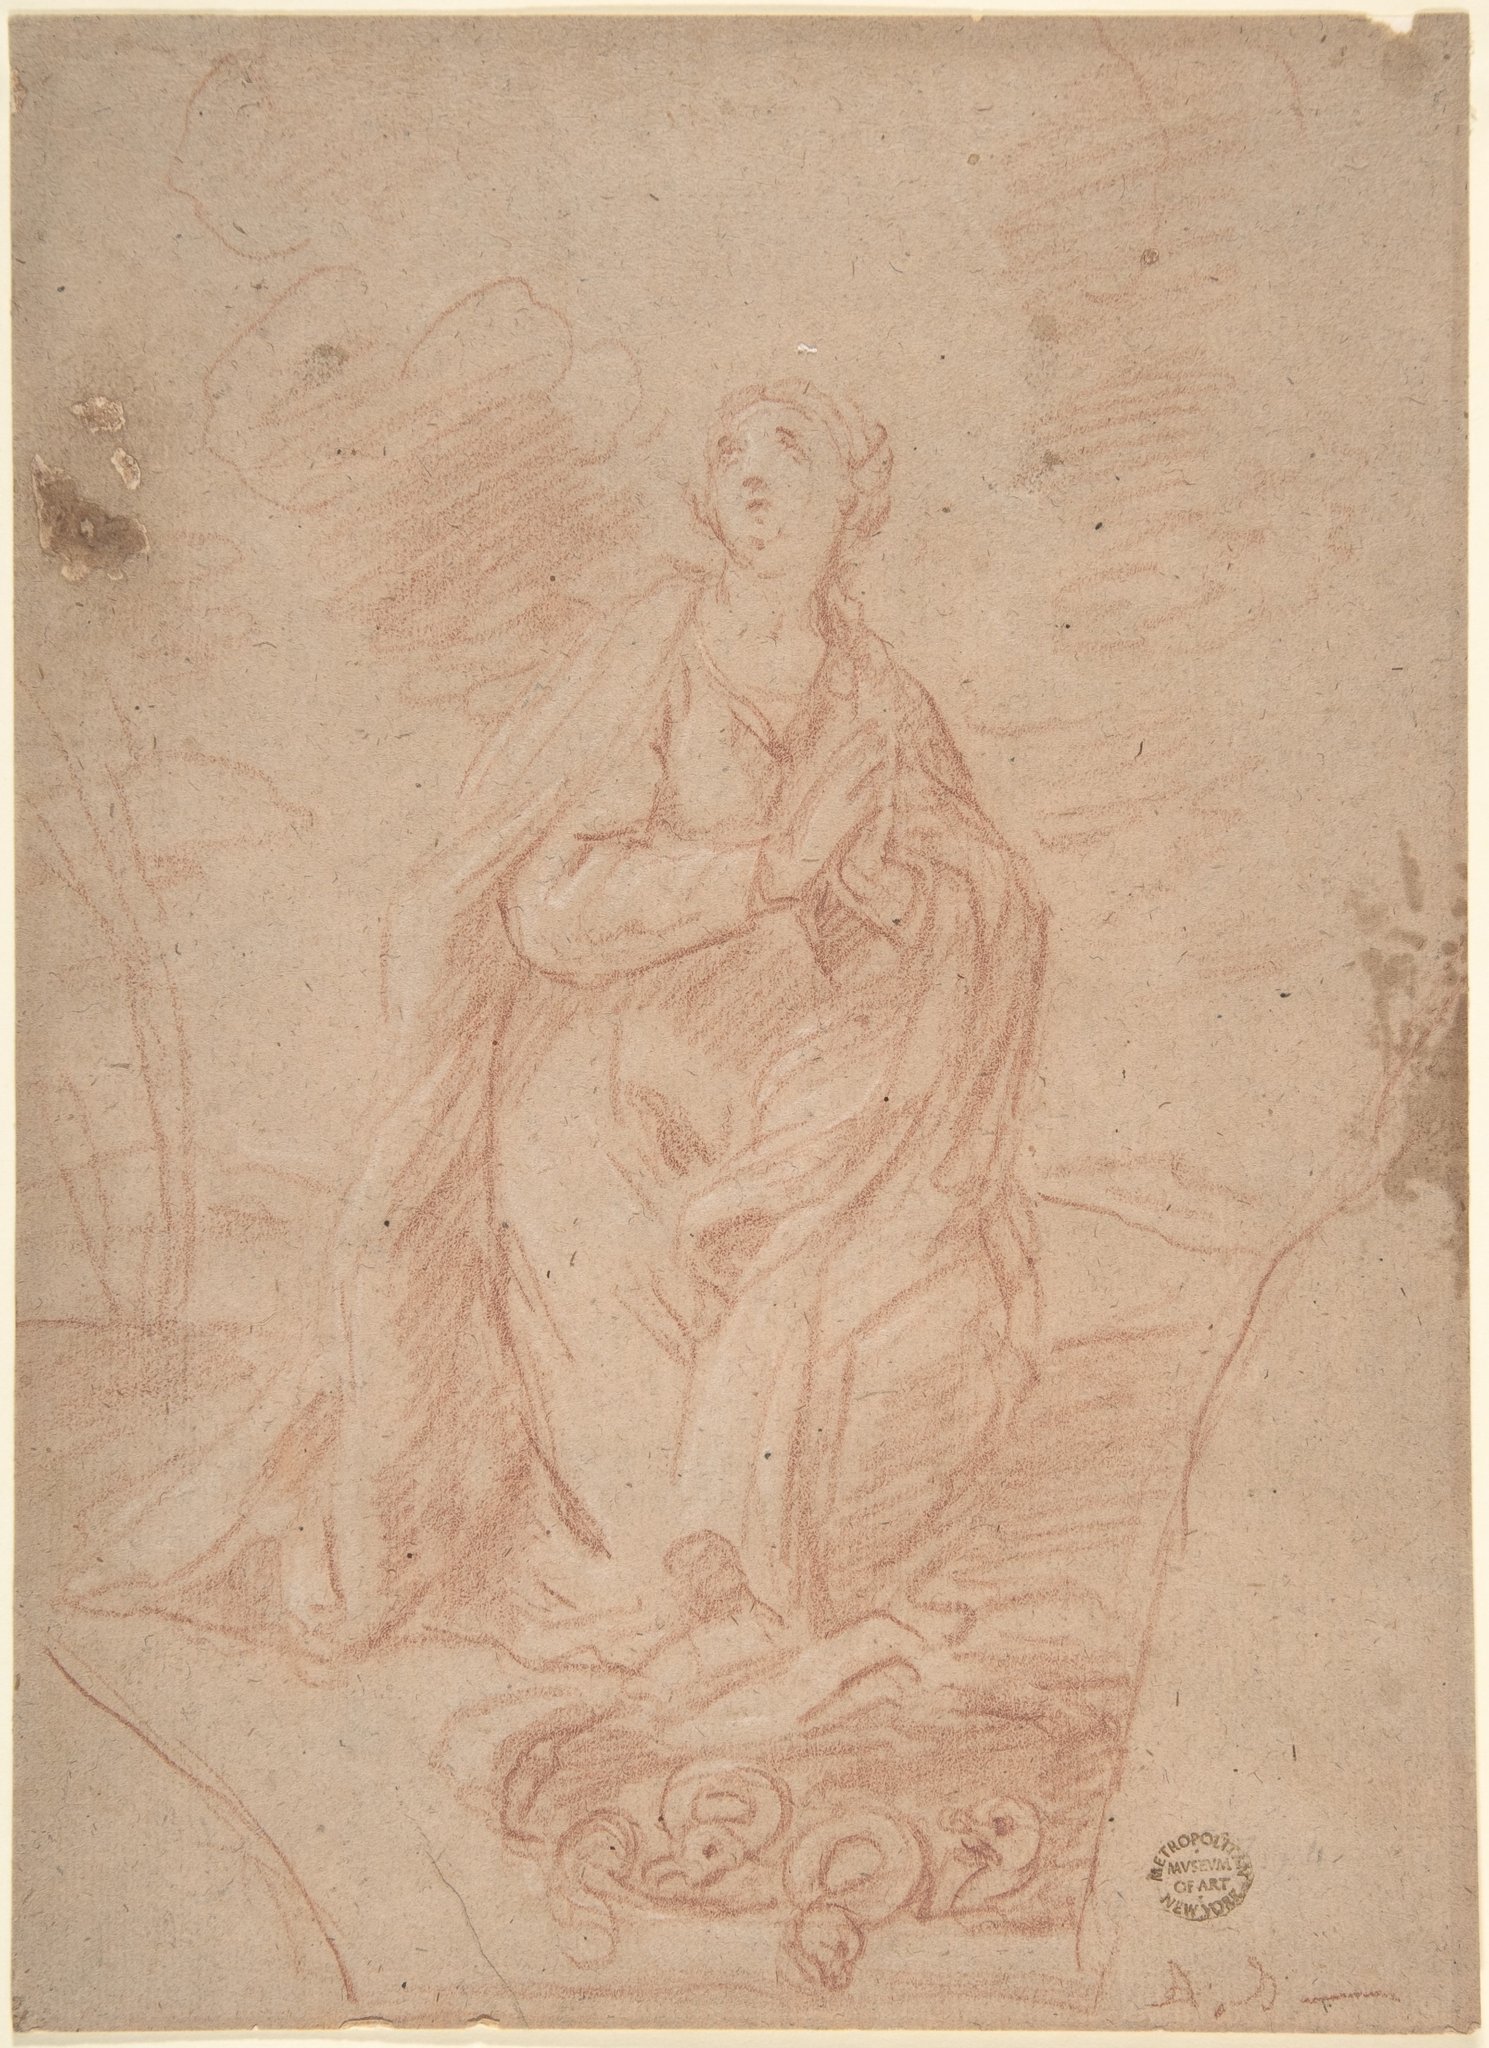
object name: drawing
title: Virgin Kneeling in Prayer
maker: anonymous, italian, roman-bolognese, 17th century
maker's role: artist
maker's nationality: italian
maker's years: 1600-1700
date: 1601-1700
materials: chalk, paper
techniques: highlighting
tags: virgin mary